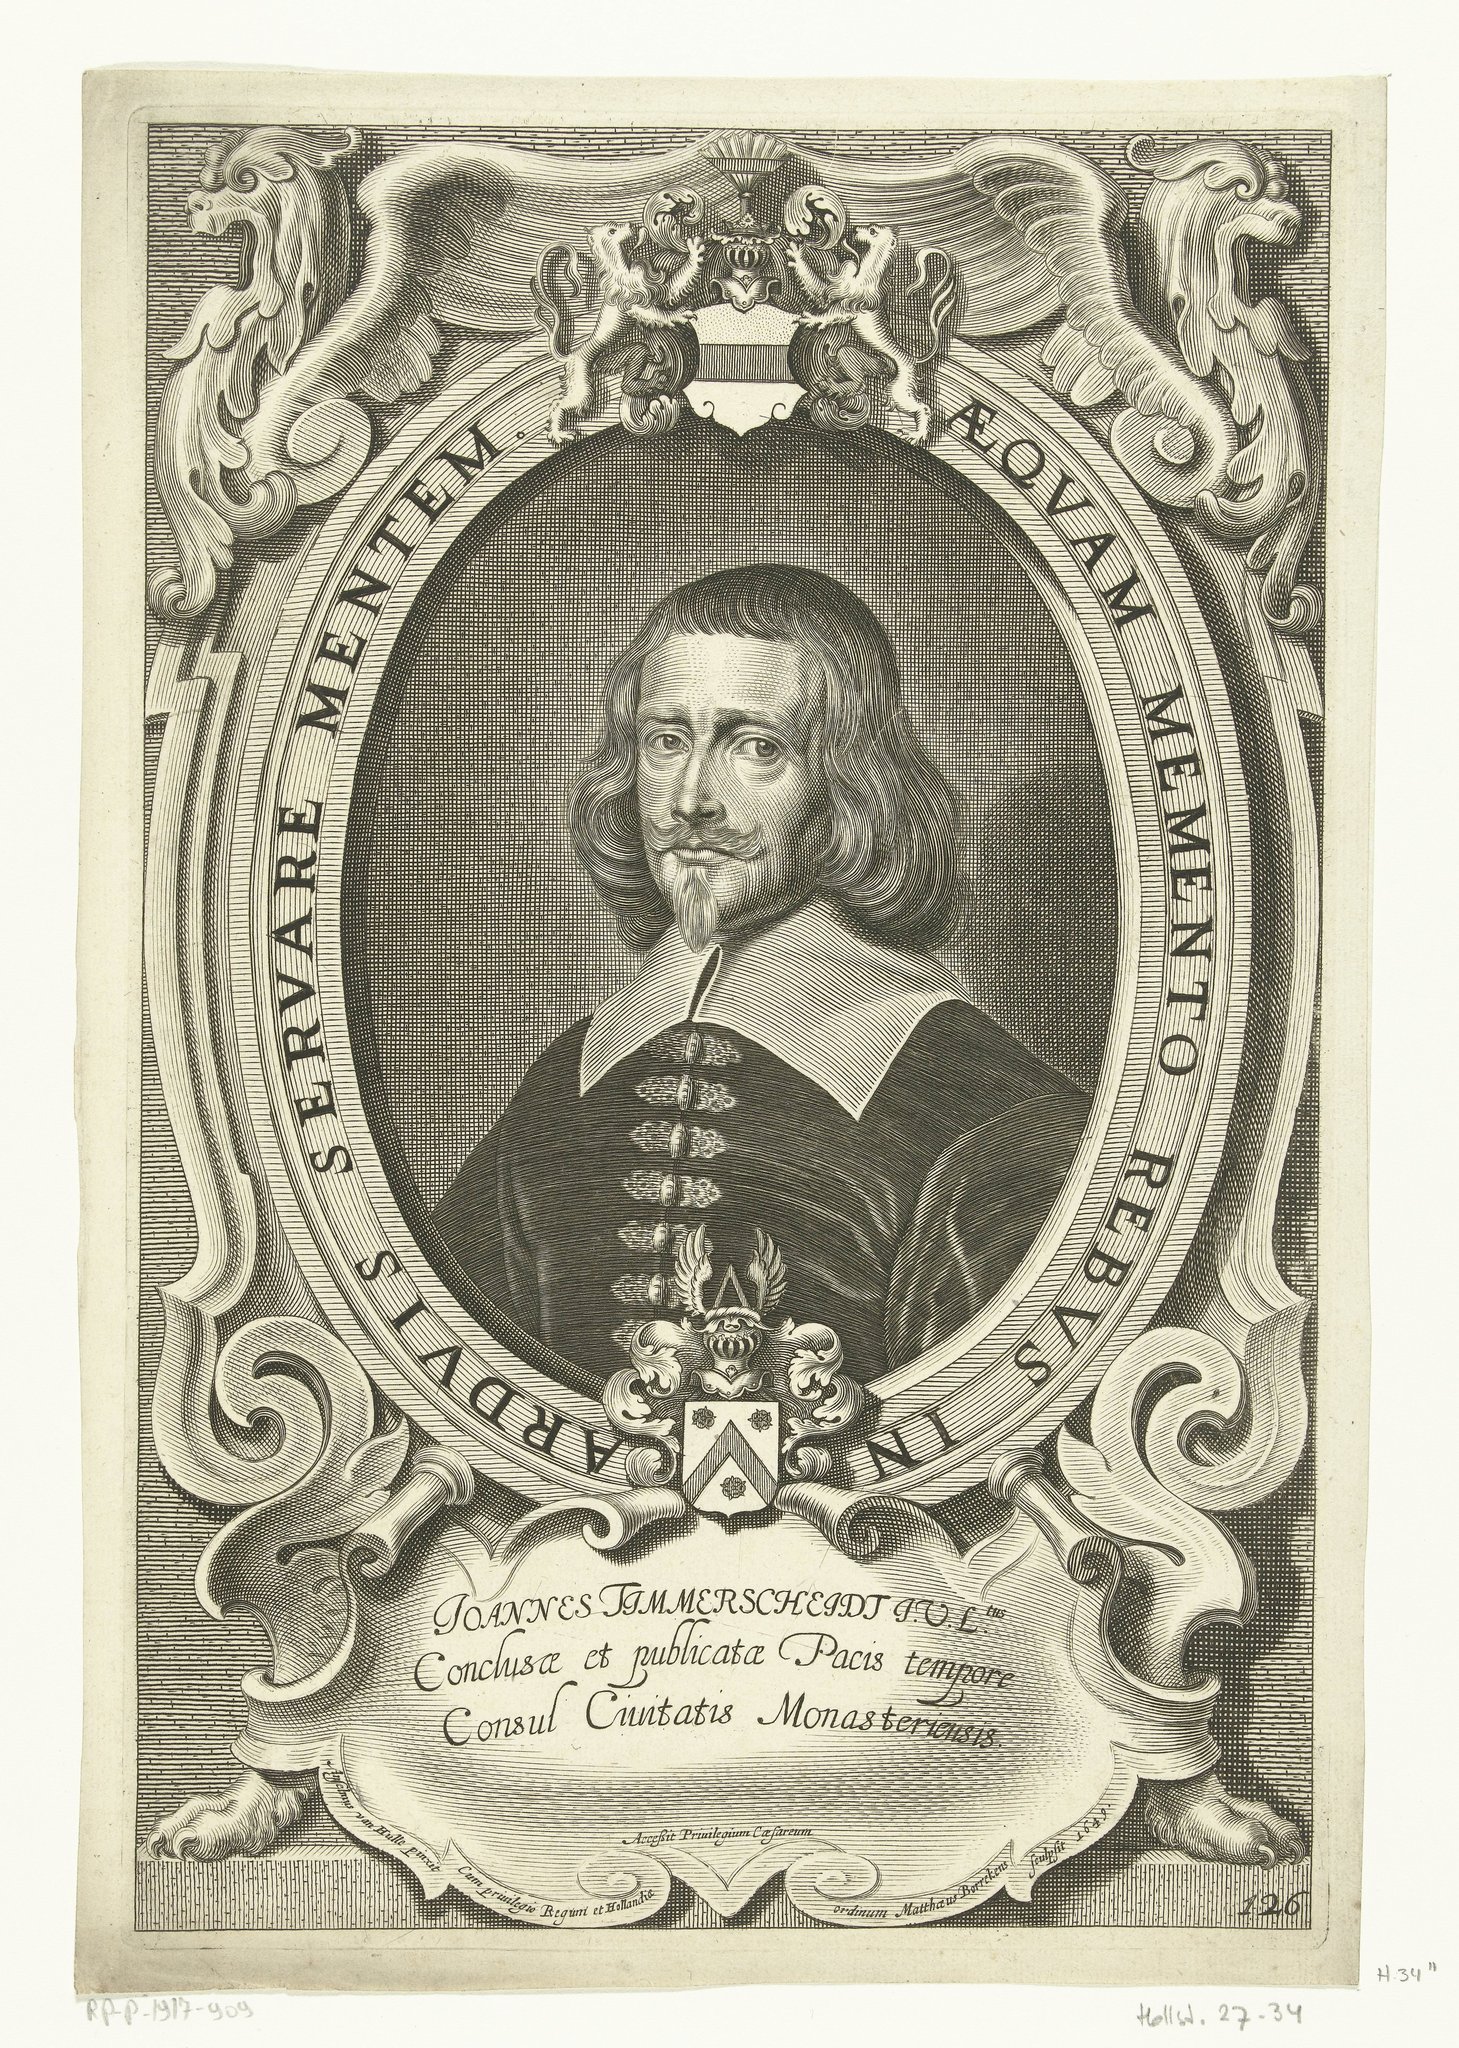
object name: print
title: Portretten van onderhandelaars bij de Vrede van Munster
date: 1649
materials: paper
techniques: engraving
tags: matthäus timmerscheidt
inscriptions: collector's mark: Lugt 2228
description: Johannes Timmerscheidt, burgemeester van Munster en onderhandelaar bij de Vrede van Munster. Portret in ovale lijst met buste naar links. De prent bevat een Latijns onderschrift in cartouche, een randschrift en ornament met wapen bovenaan en onderaan.